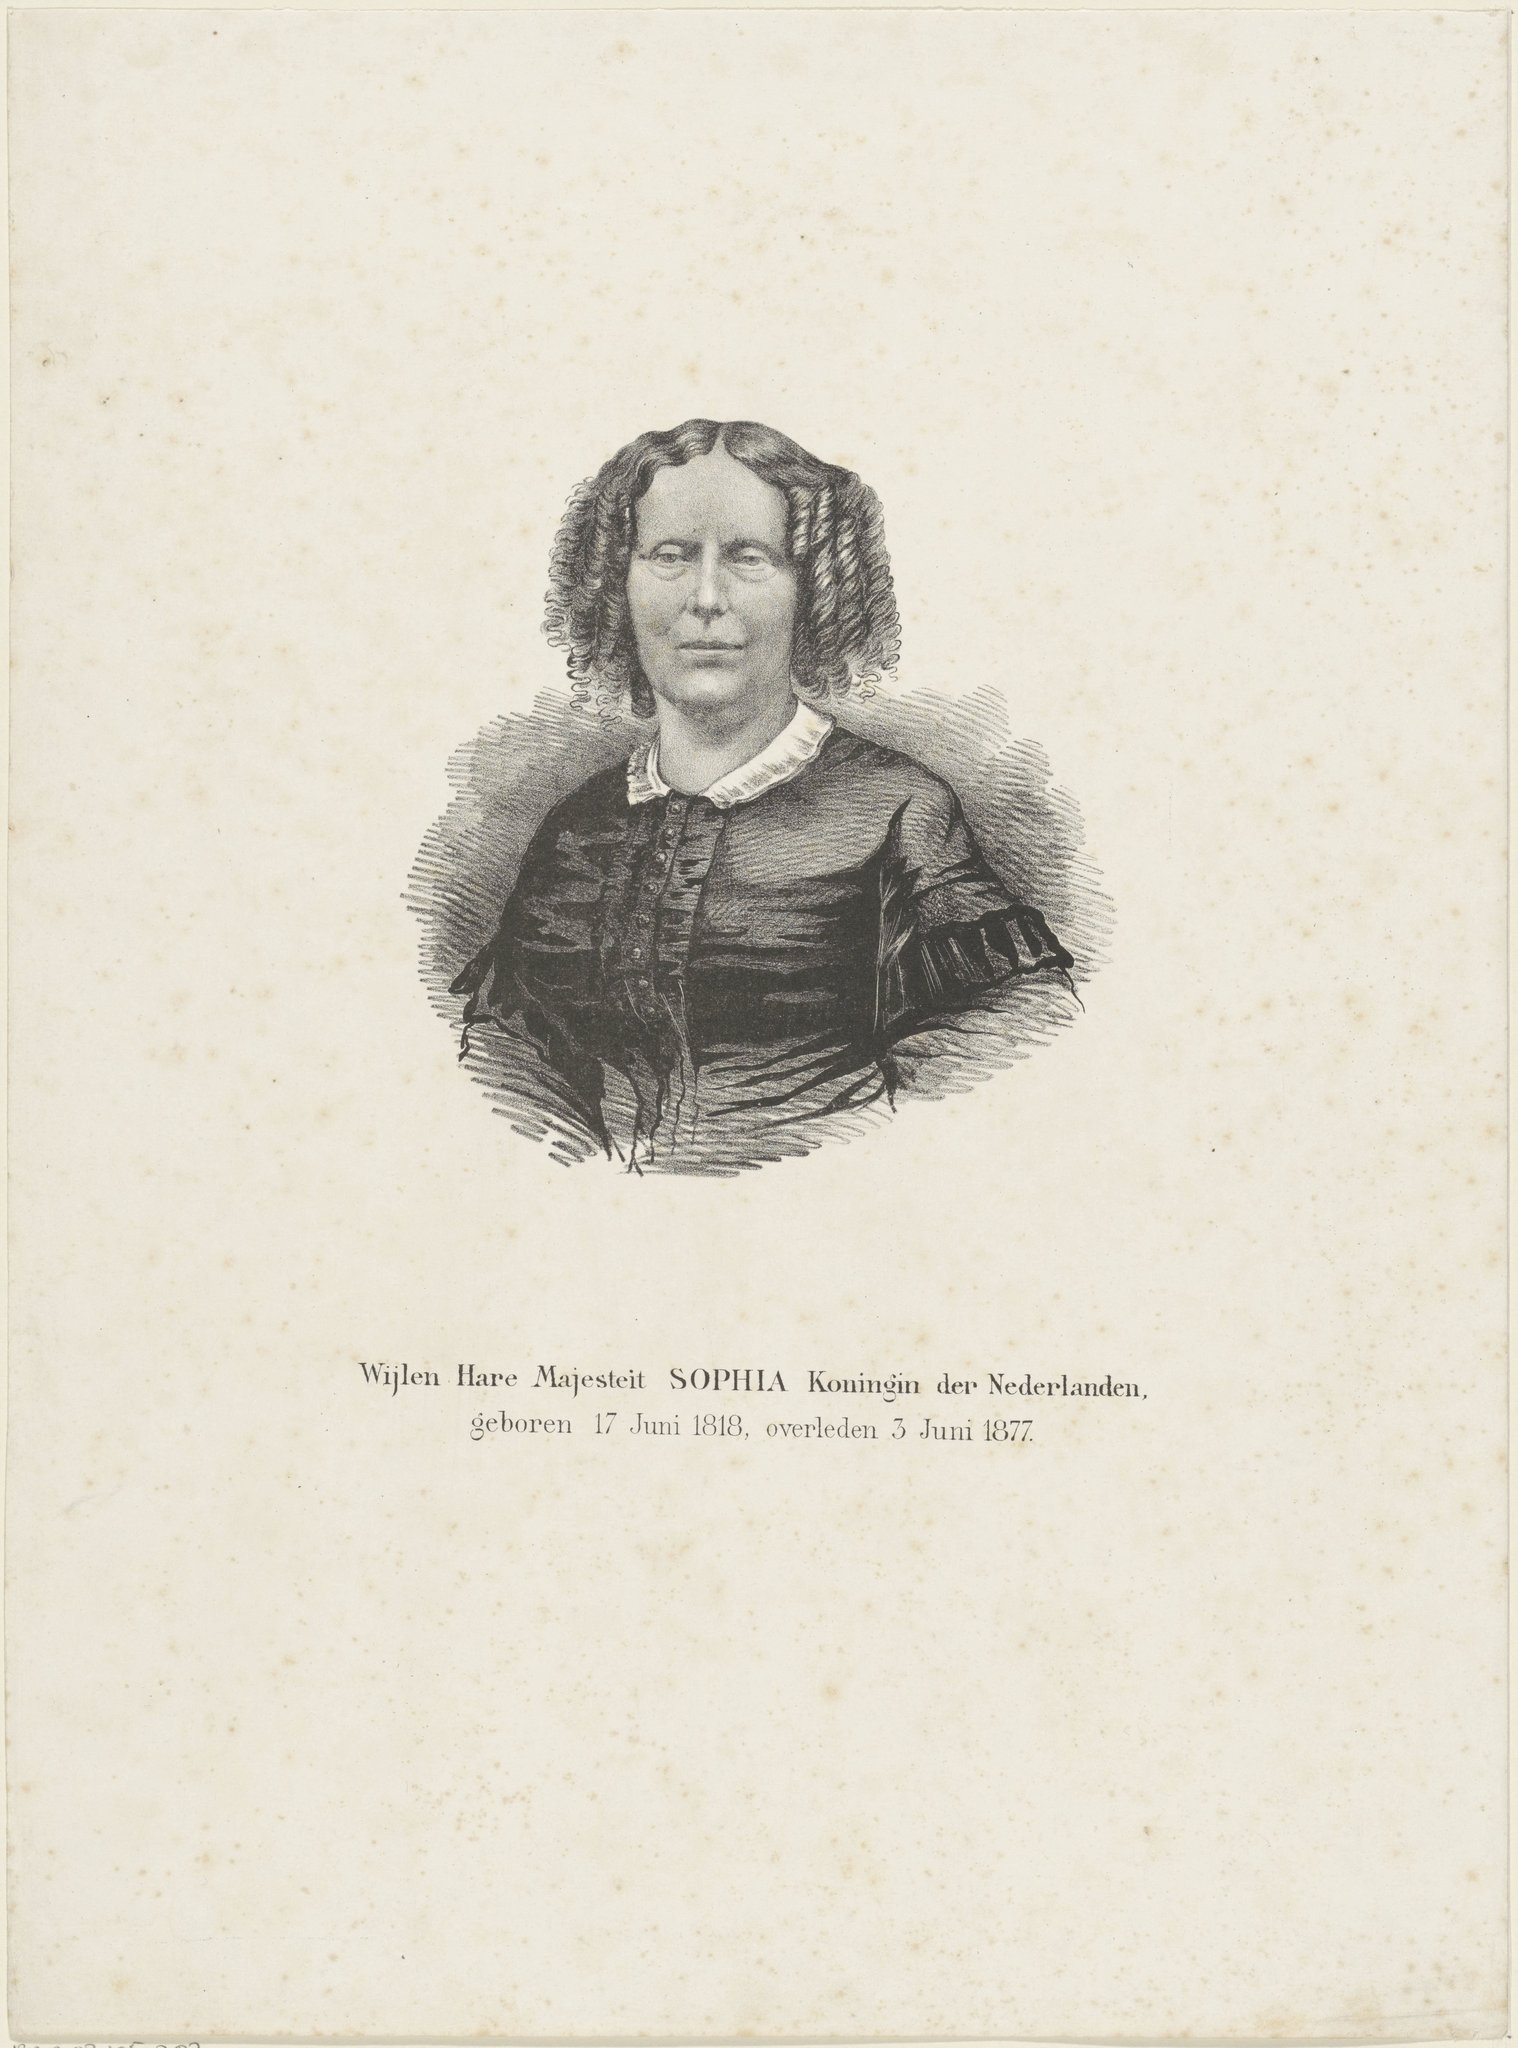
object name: print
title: Portret van Sophie van Württemberg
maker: Anonymous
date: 1877-1949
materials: paper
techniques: lithograph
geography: netherlands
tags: the hague, sophia frederika mathilda van württemberg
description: Portret van Sophie. In de ondermarge haar naam, titel, haar geboortedatum en sterfdatum.